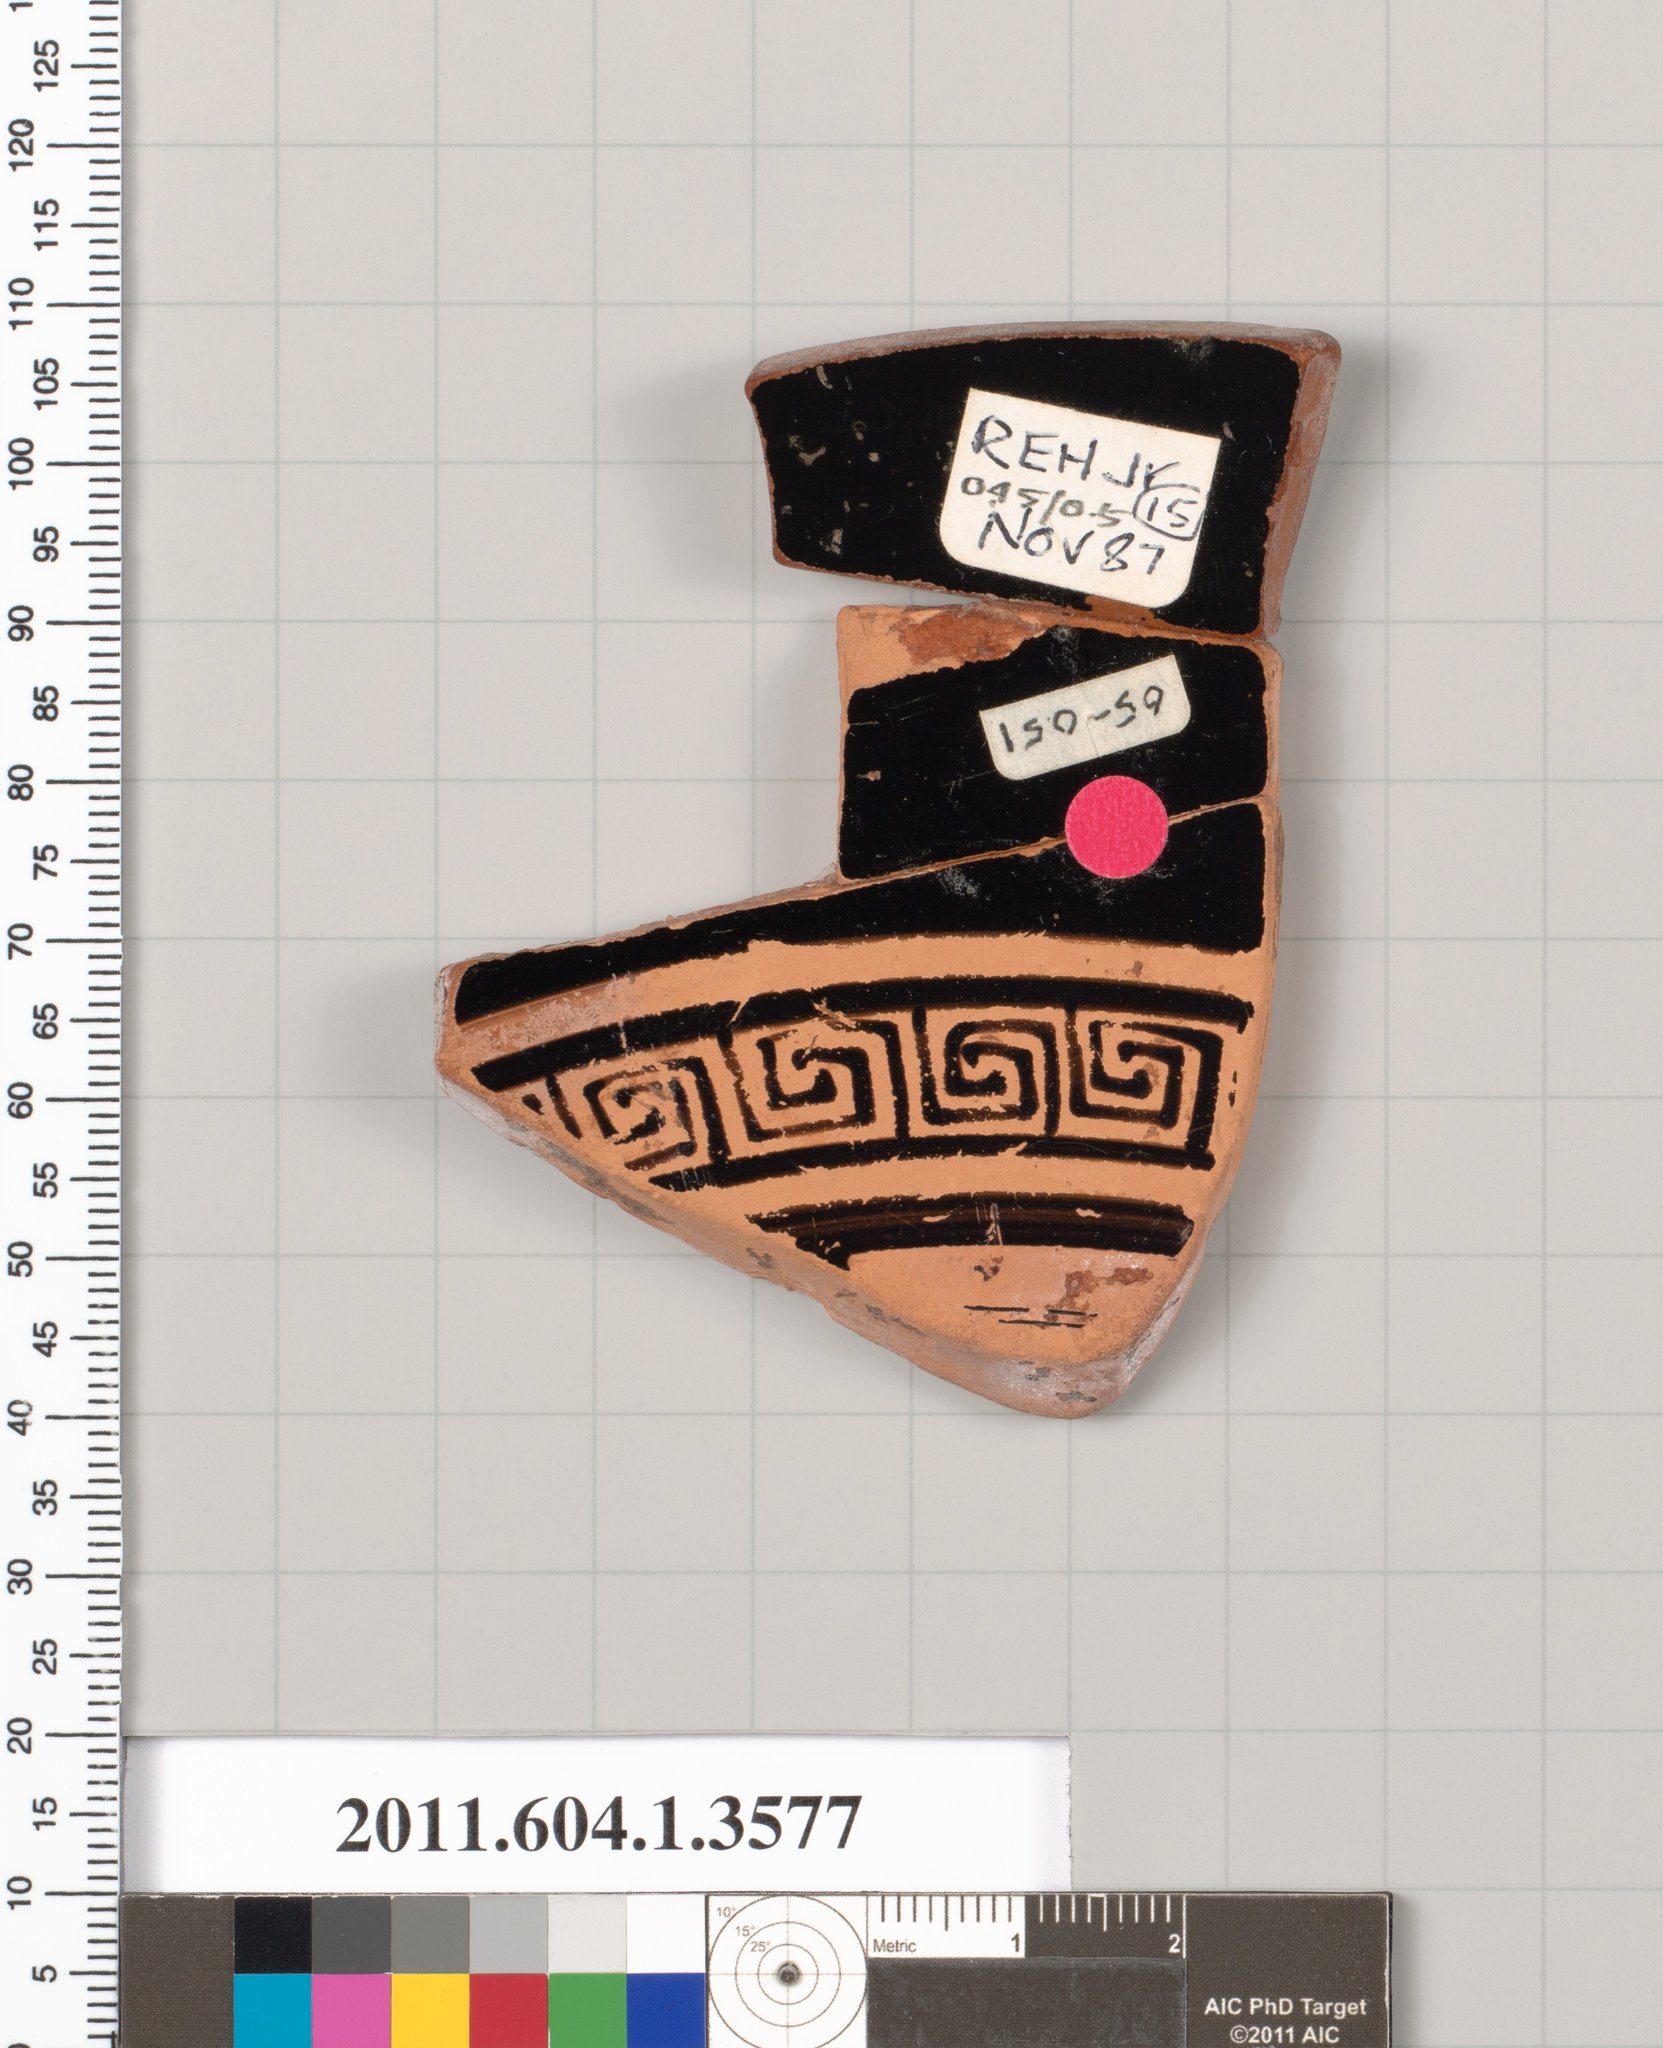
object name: kylix fragment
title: Terracotta fragment of a kylix (drinking cup)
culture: greek, attic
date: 475-451 BCE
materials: terracotta